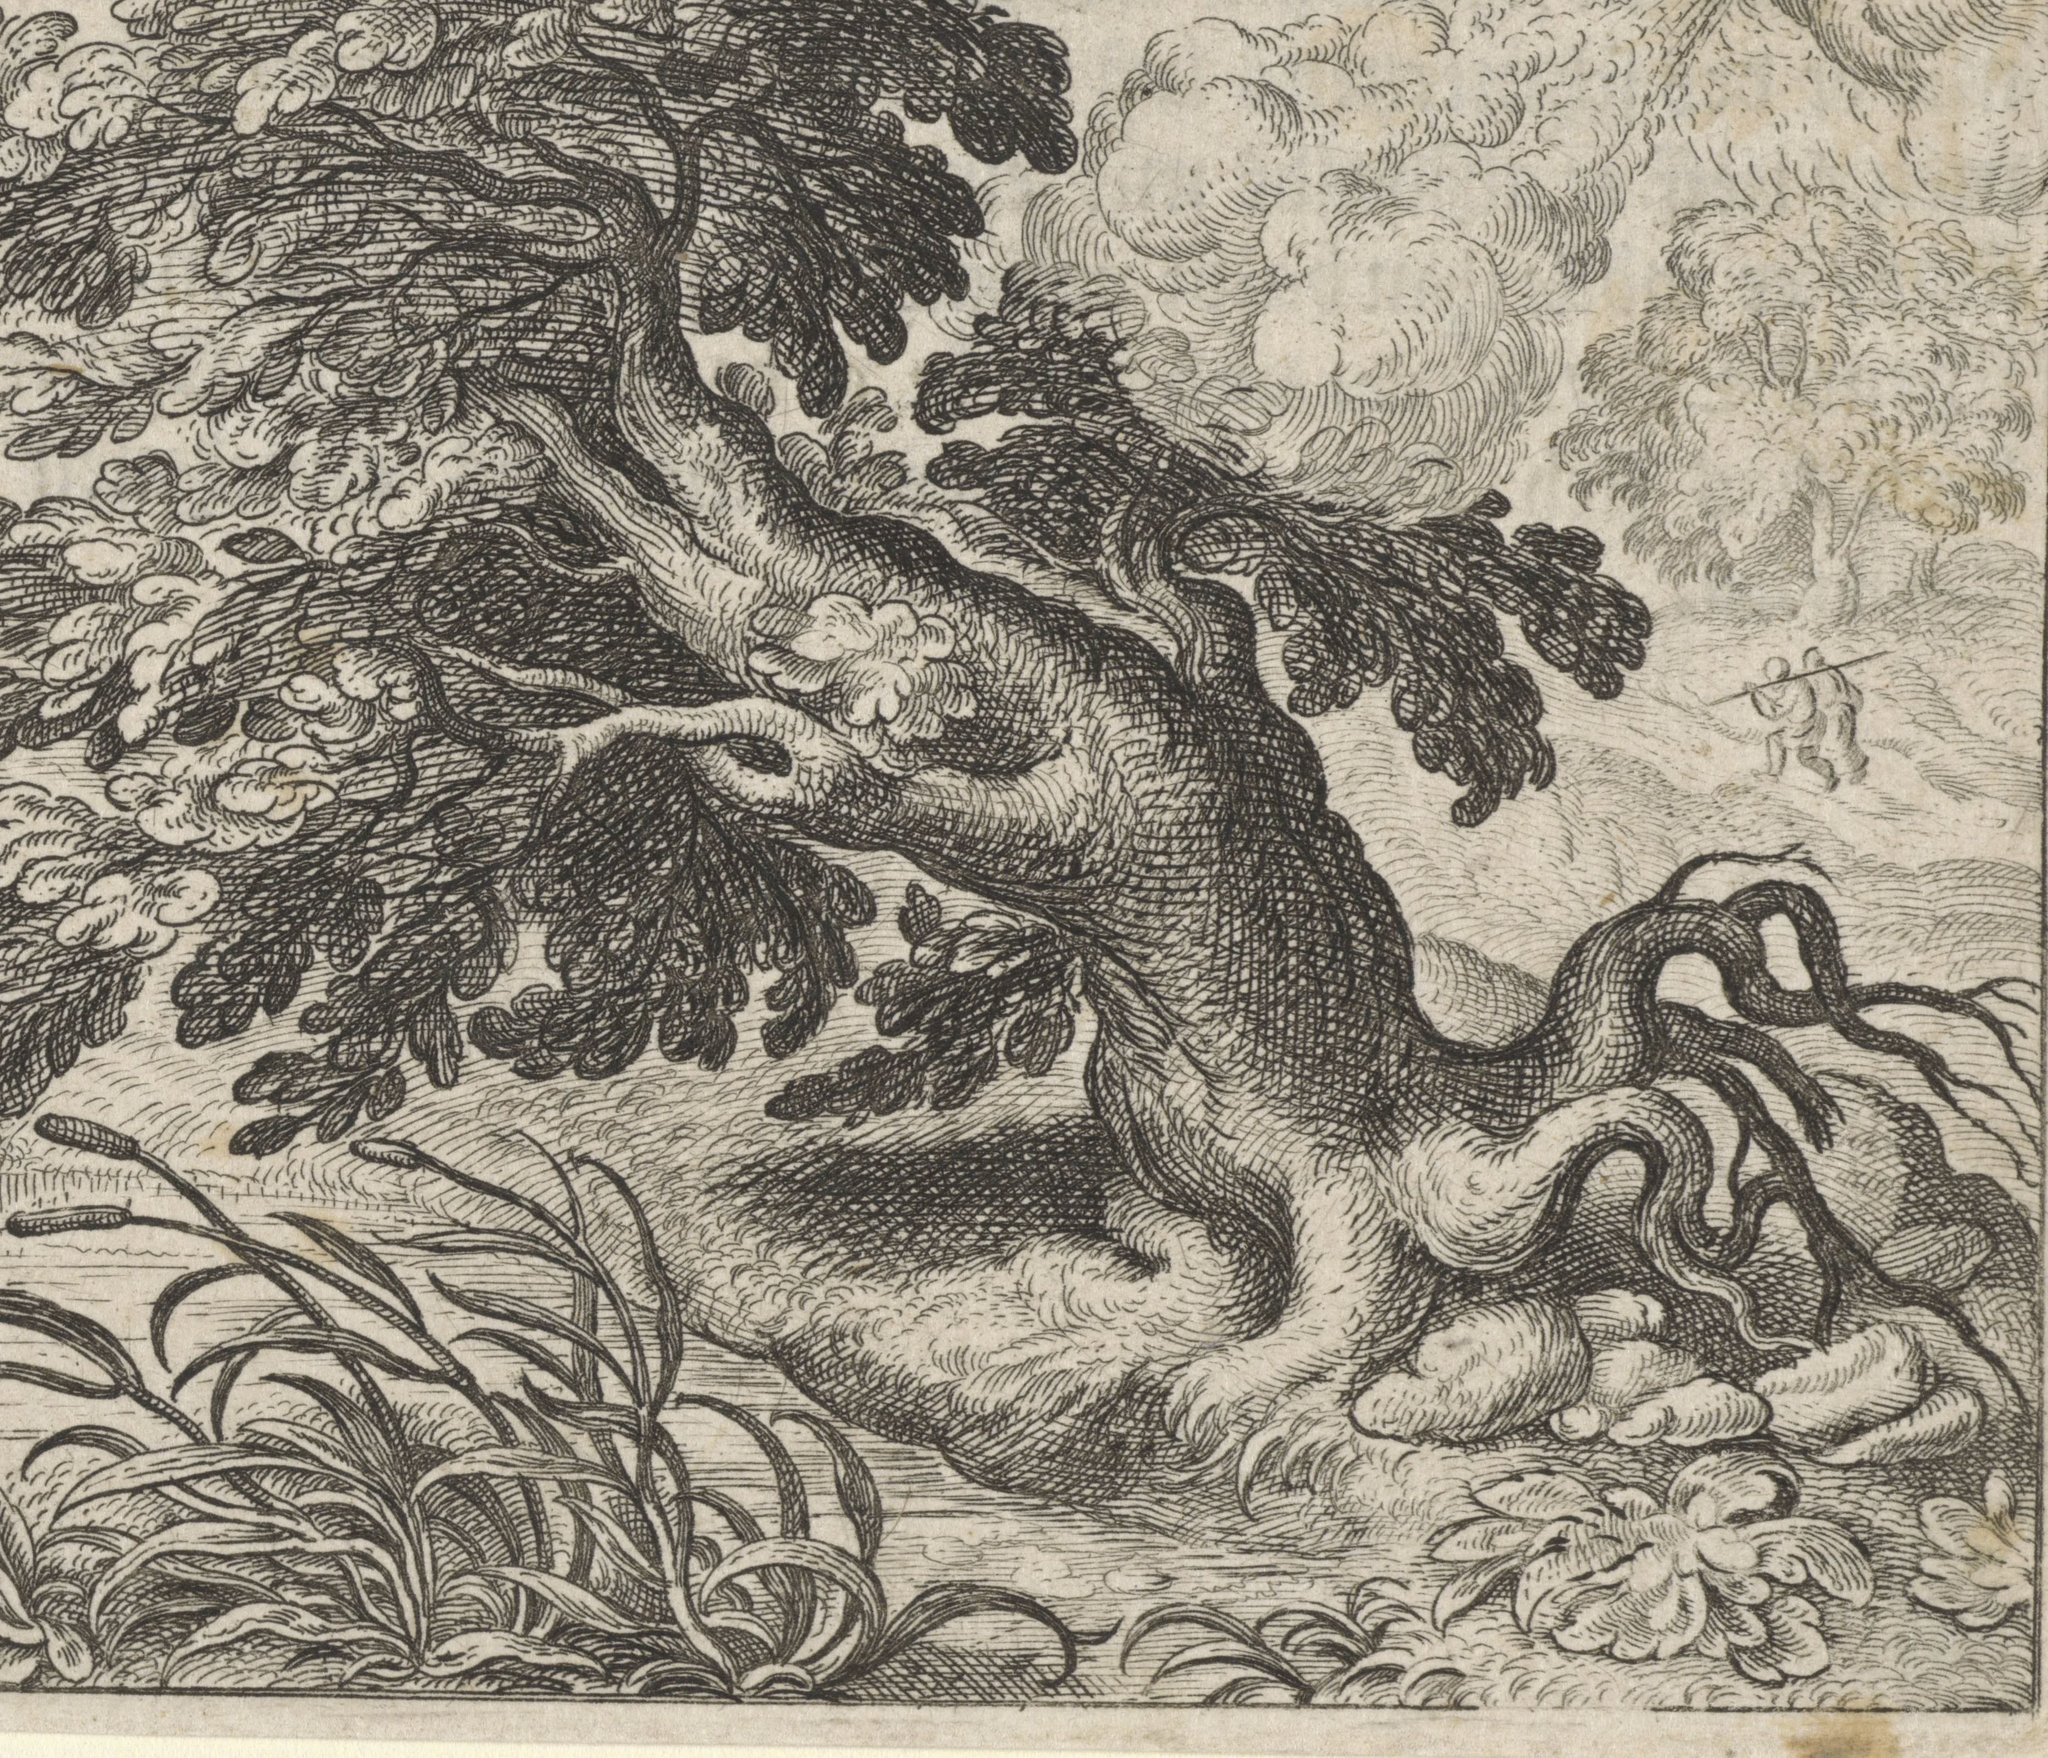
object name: book illustration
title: Fabel van de es en het riet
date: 1608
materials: paper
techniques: engraving, etching, letterpress printing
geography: prague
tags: trees: ash-tree, plants and herbs: reed, fables, storm, gods of the winds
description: Een es wordt door de wind omvergeblazen en ontworteld. Op de voorgrond bundels riet die met de wind mee waaien. De fabel beschrijft hoe de es zichzelf beter vond dan het riet, maar door een stormwind wordt ontworteld, terwijl het riet geen last heeft van de wind. De moraal van het verhaal leert dat hoogmoed voor de val komt.